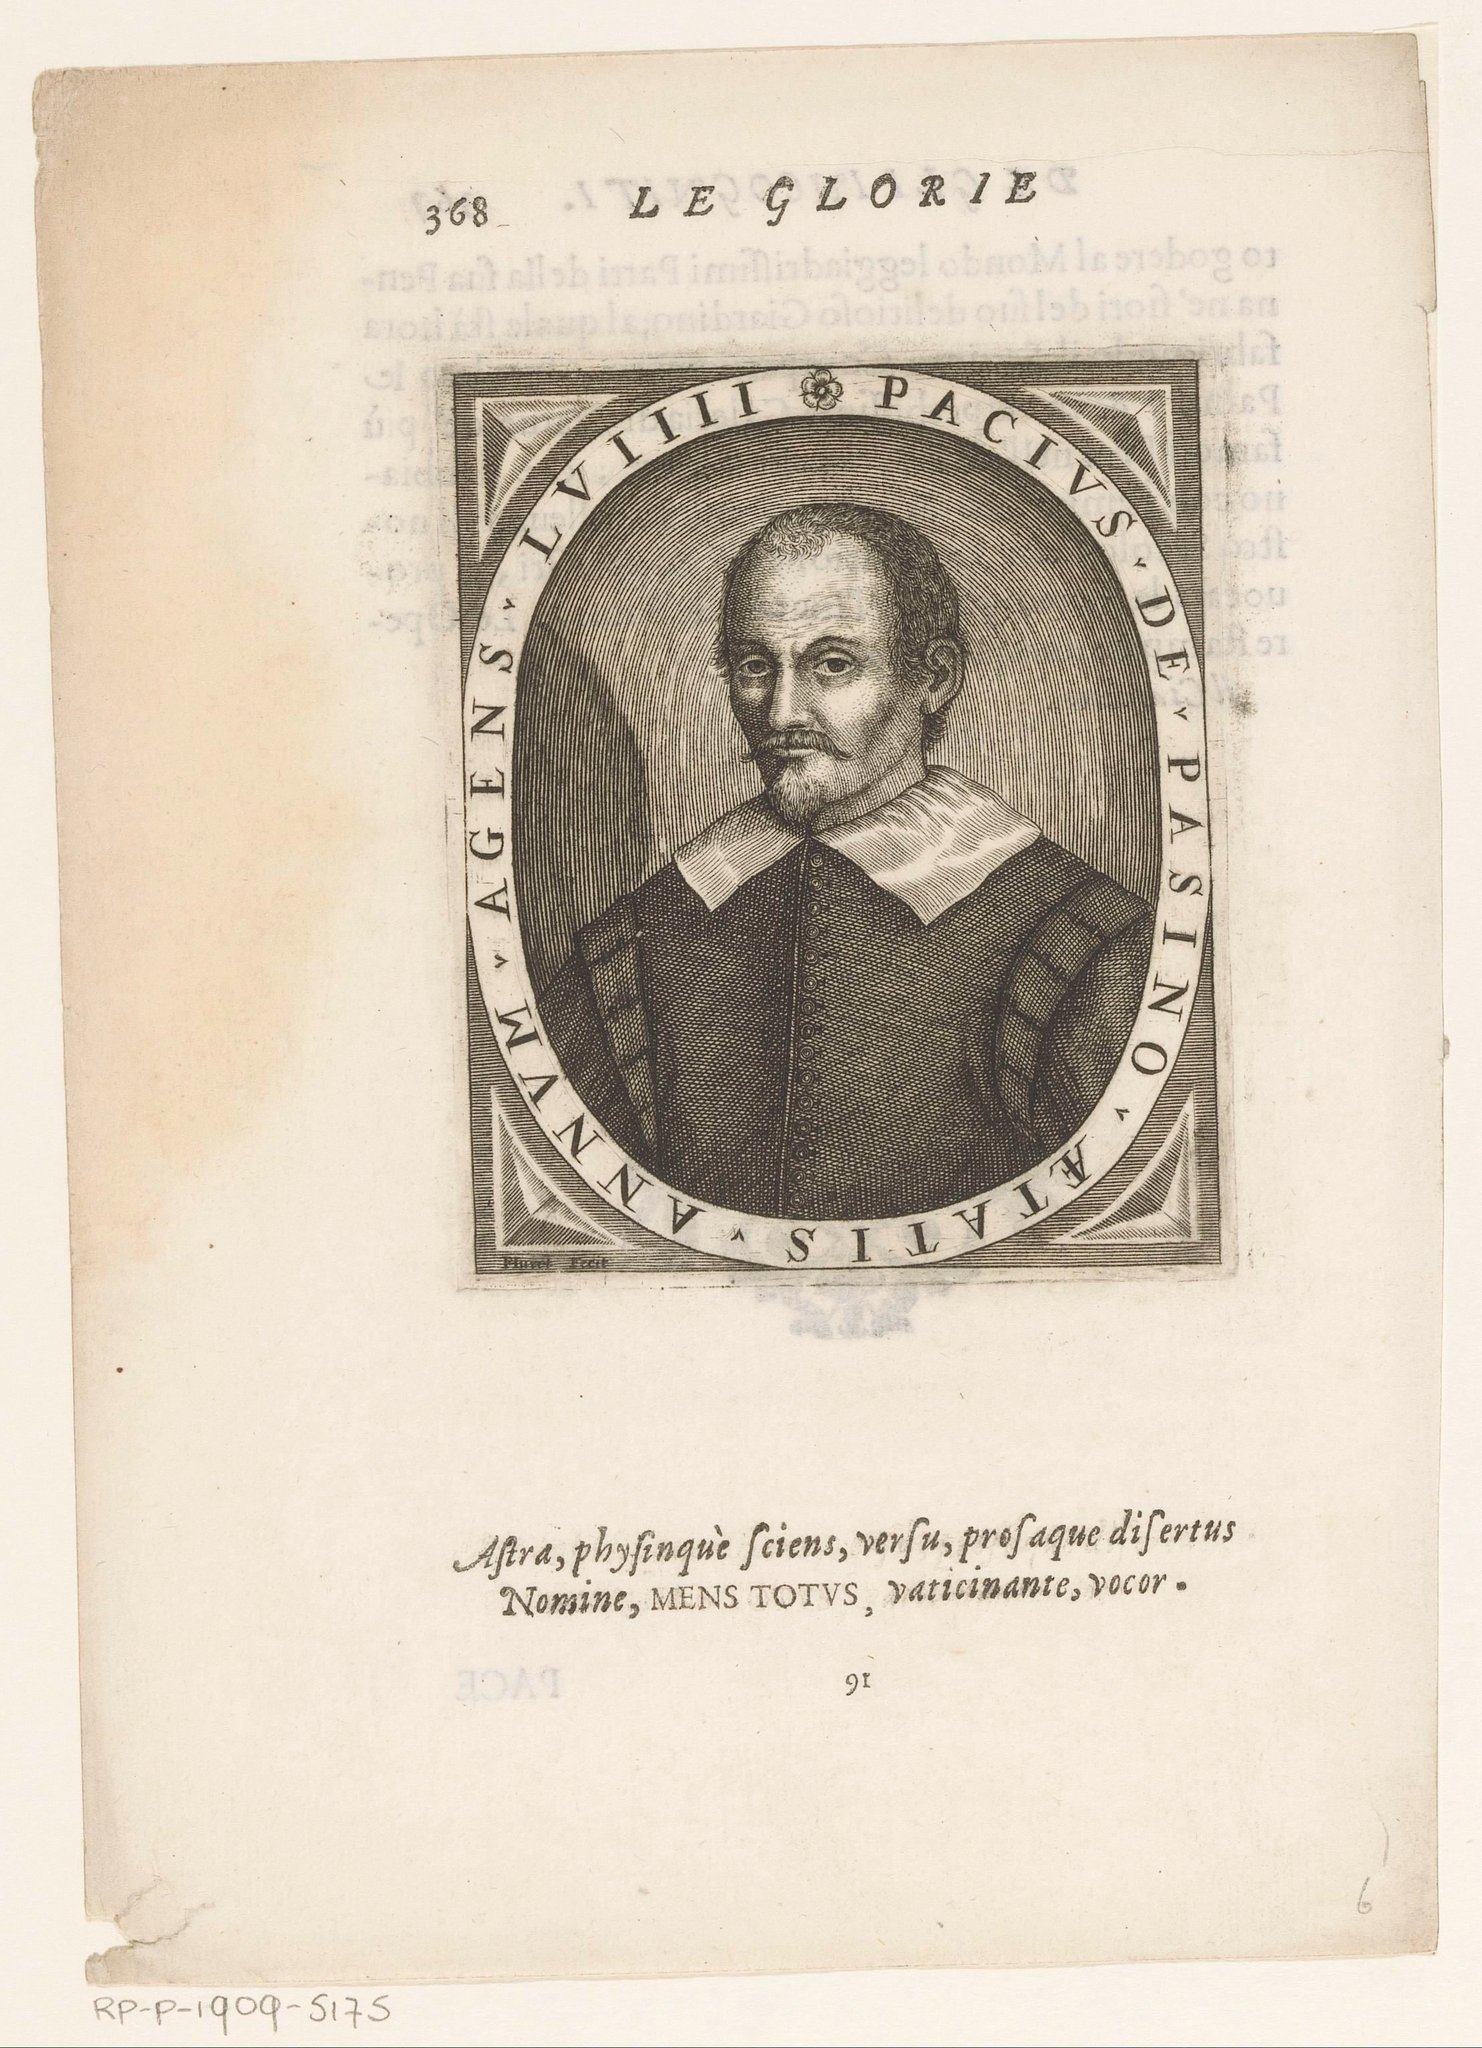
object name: book illustration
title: Portret van dichter en filosoof Pace Pasini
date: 1647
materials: paper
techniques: engraving, letterpress printing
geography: venice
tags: historical persons, writer, poet, author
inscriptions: collector's mark: Lugt 2228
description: Prent uit de publicatie: Loredan, Giovan Francesco. Le glorie degli Incogniti. Venetië: Francesco Valvasense, 1647, p. 368.